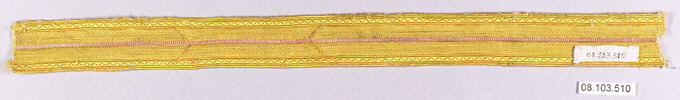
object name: galloon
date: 1701-1800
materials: cotton, silk